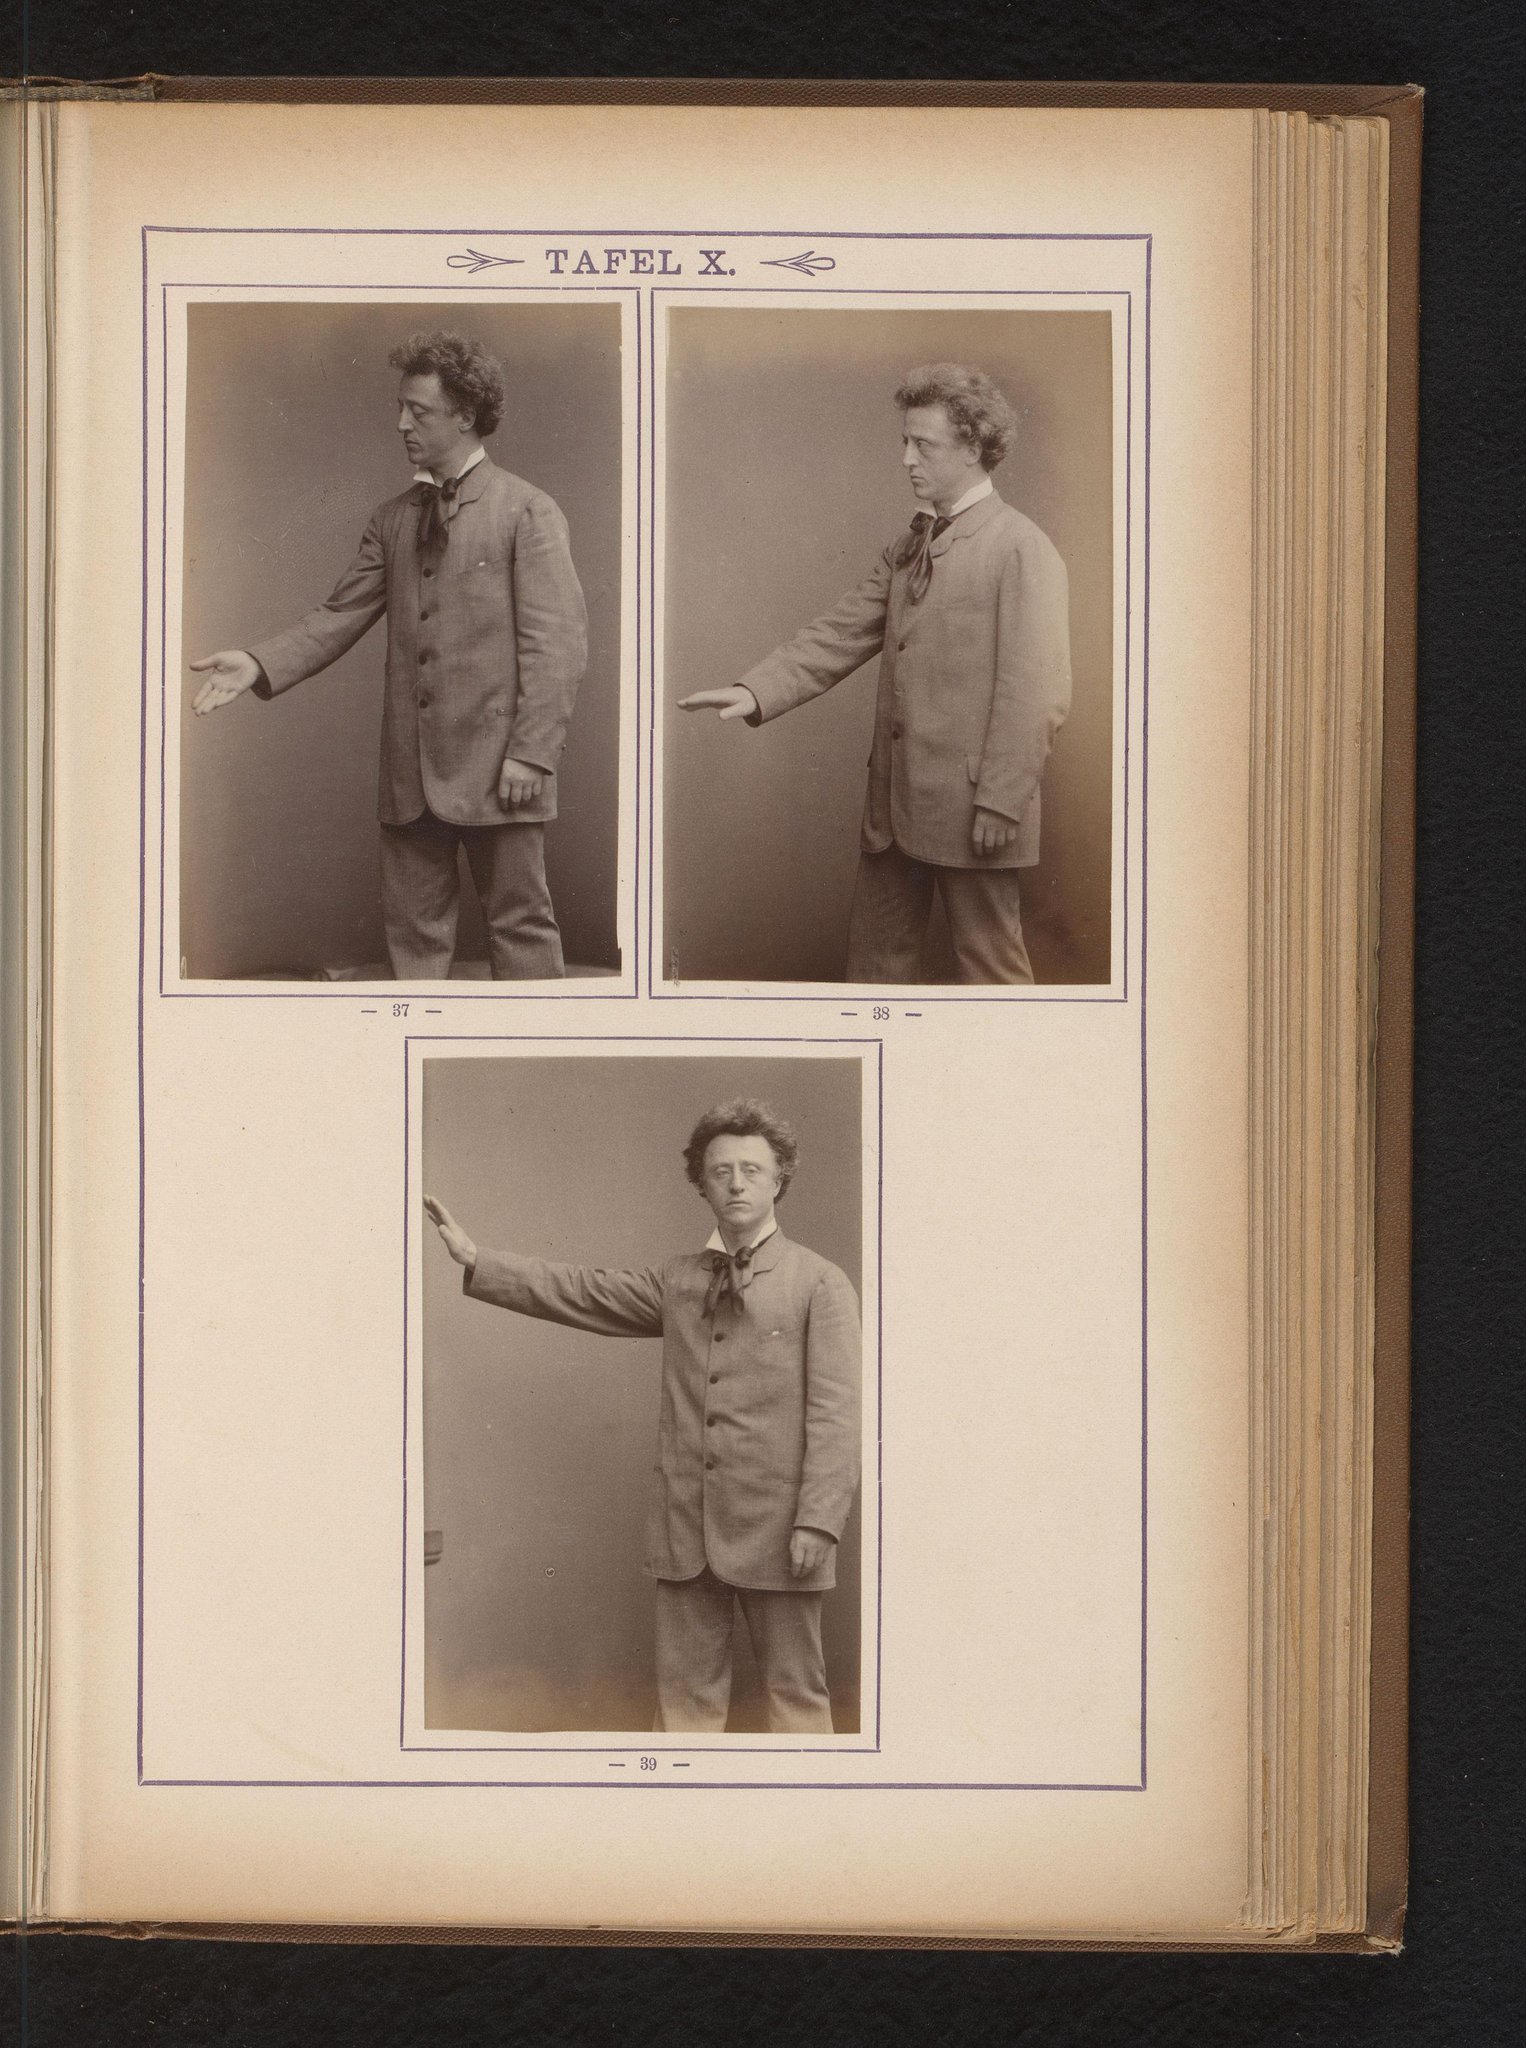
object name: photograph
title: Drie portretten van een man met verschillende bewegingen van zijn bovenarm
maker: nicola tonger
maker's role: fotograaf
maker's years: 1846-1917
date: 1881-1886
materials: paper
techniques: albumen print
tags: gesture-language, postures and gestures of arms and hands in general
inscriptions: number: ‘37 - 39’, number: ‘TAFEL X.’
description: Foto op negentiende ongenummerde pagina na pagina 6.